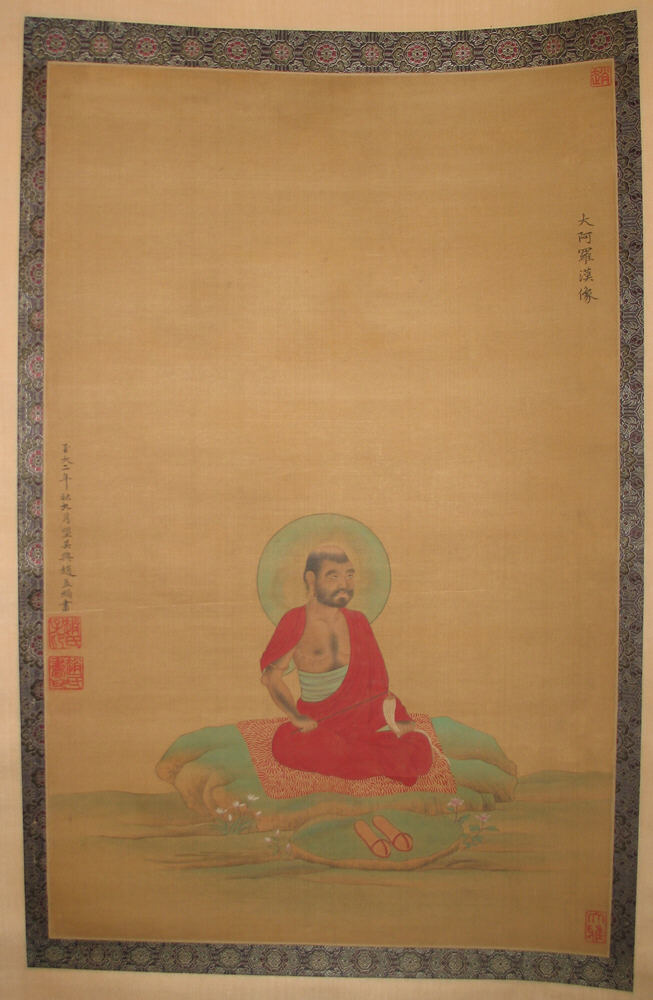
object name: hanging scroll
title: Luohan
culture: chinese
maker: unidentified artist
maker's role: artist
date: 1644-1911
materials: ink, silk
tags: men,buddhism